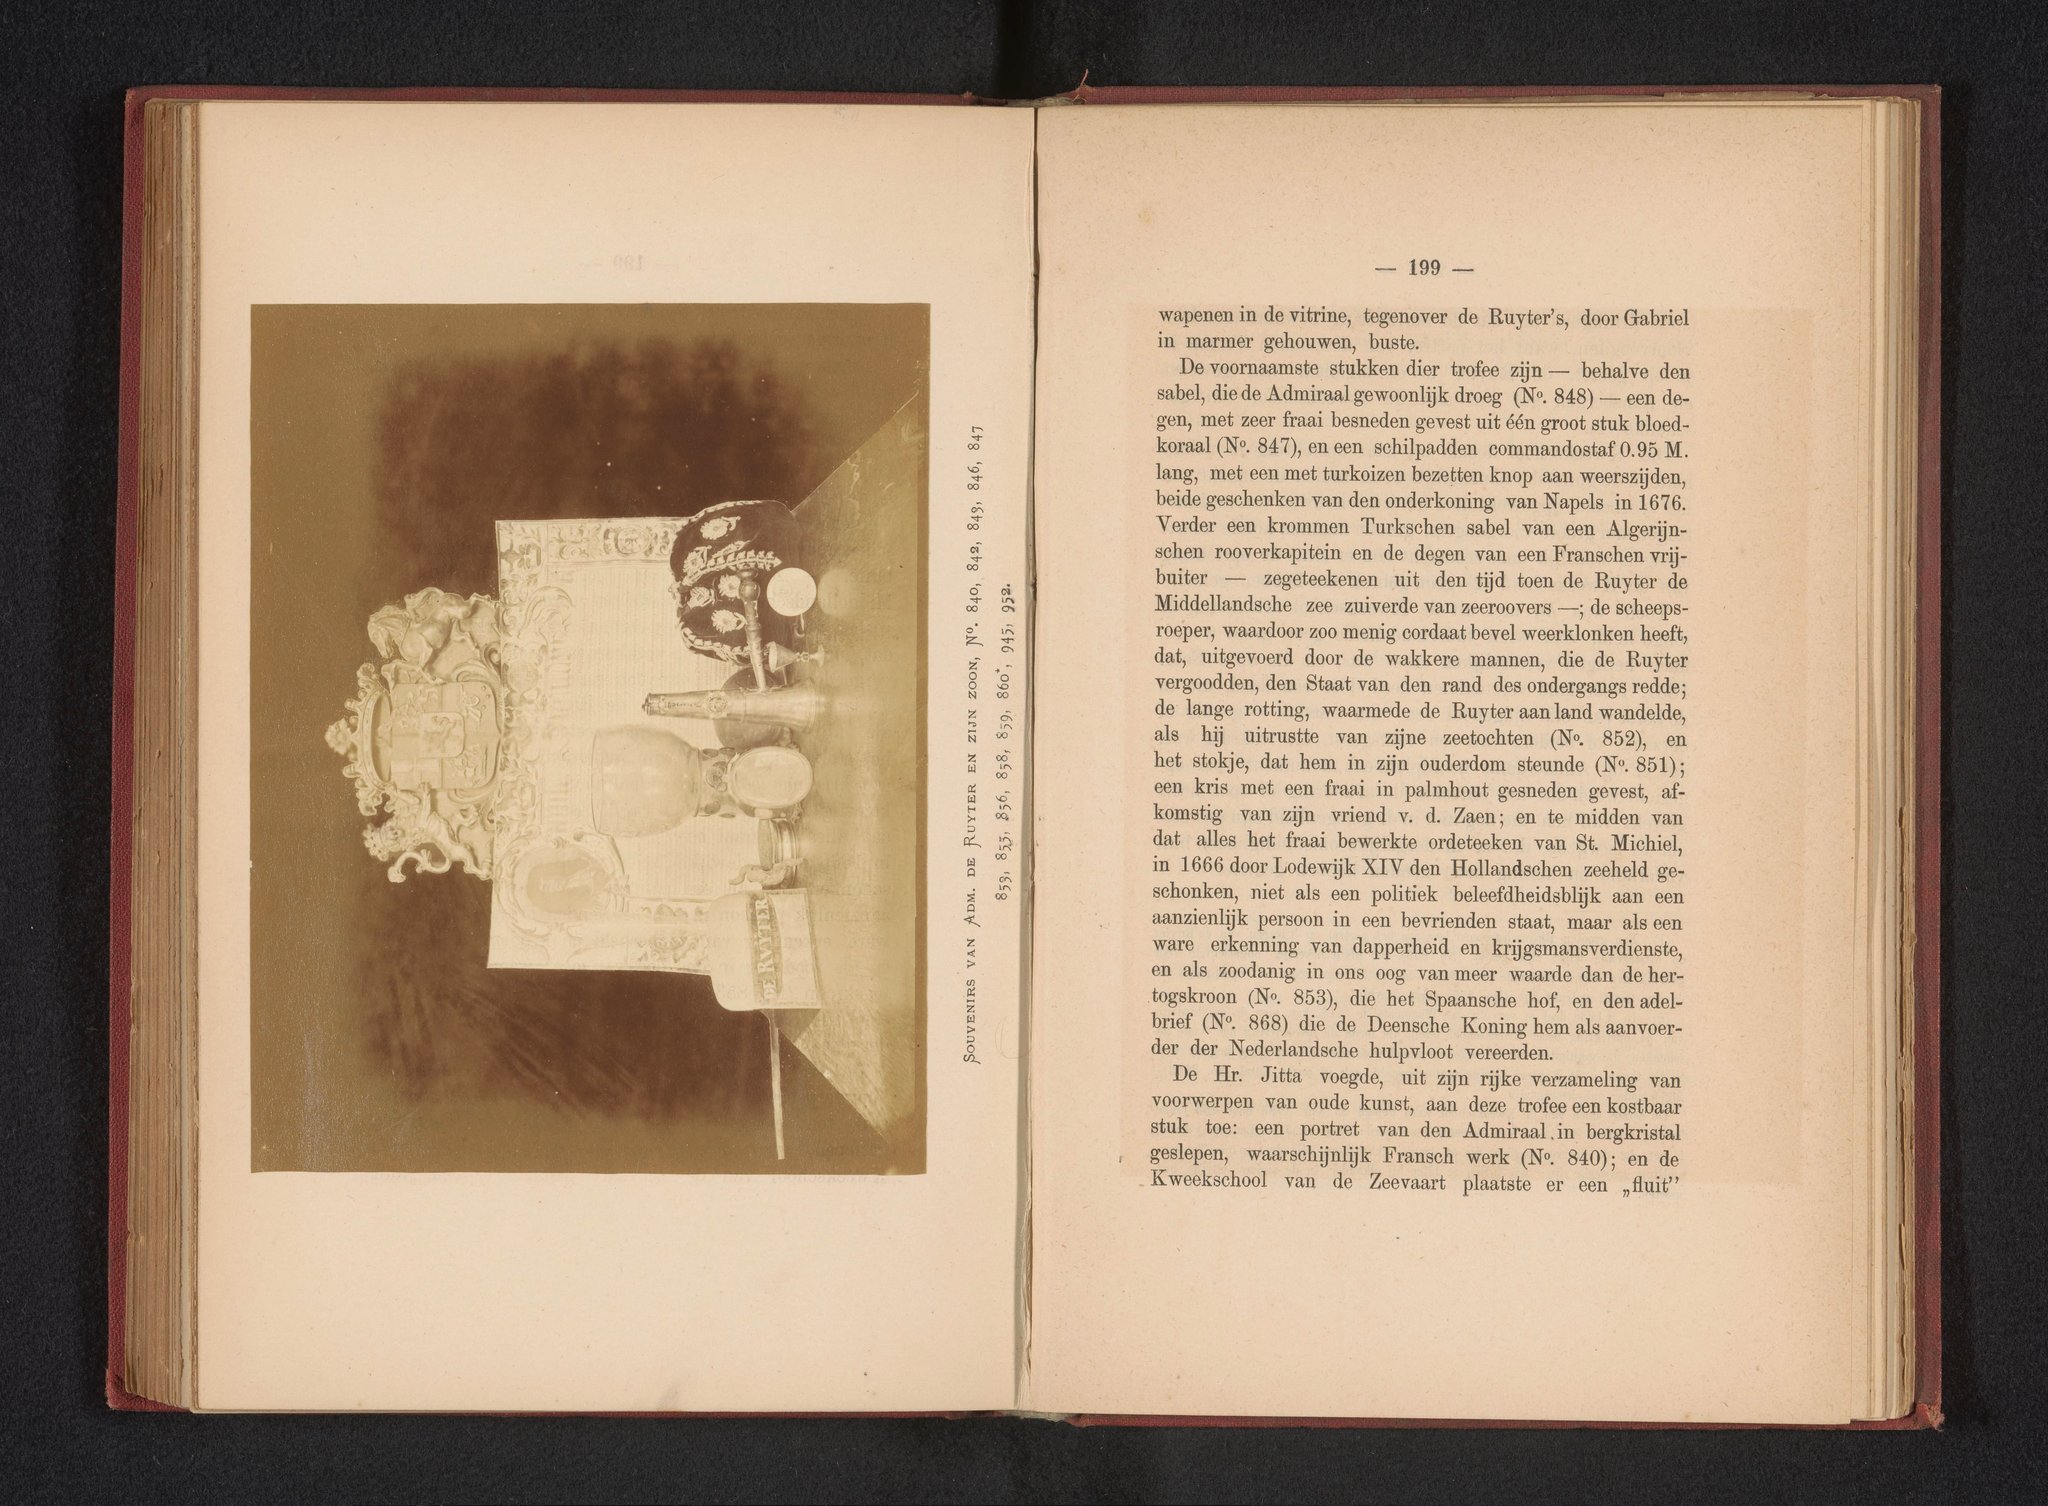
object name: photograph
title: Verzameling souvenirs van admiraal Michiel de Ruyter en zijn zoon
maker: pieter oosterhuis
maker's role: draughtsman, print maker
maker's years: 1816-1885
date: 1876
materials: photographic support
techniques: albumen print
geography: amsterdam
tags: medal, badge of a guild, glass, rummer, container of precious metal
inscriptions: number: ‘No. 840, 842, 843, 846, 847/ 853, 855, 856, 859, 860*, 945, 952.’